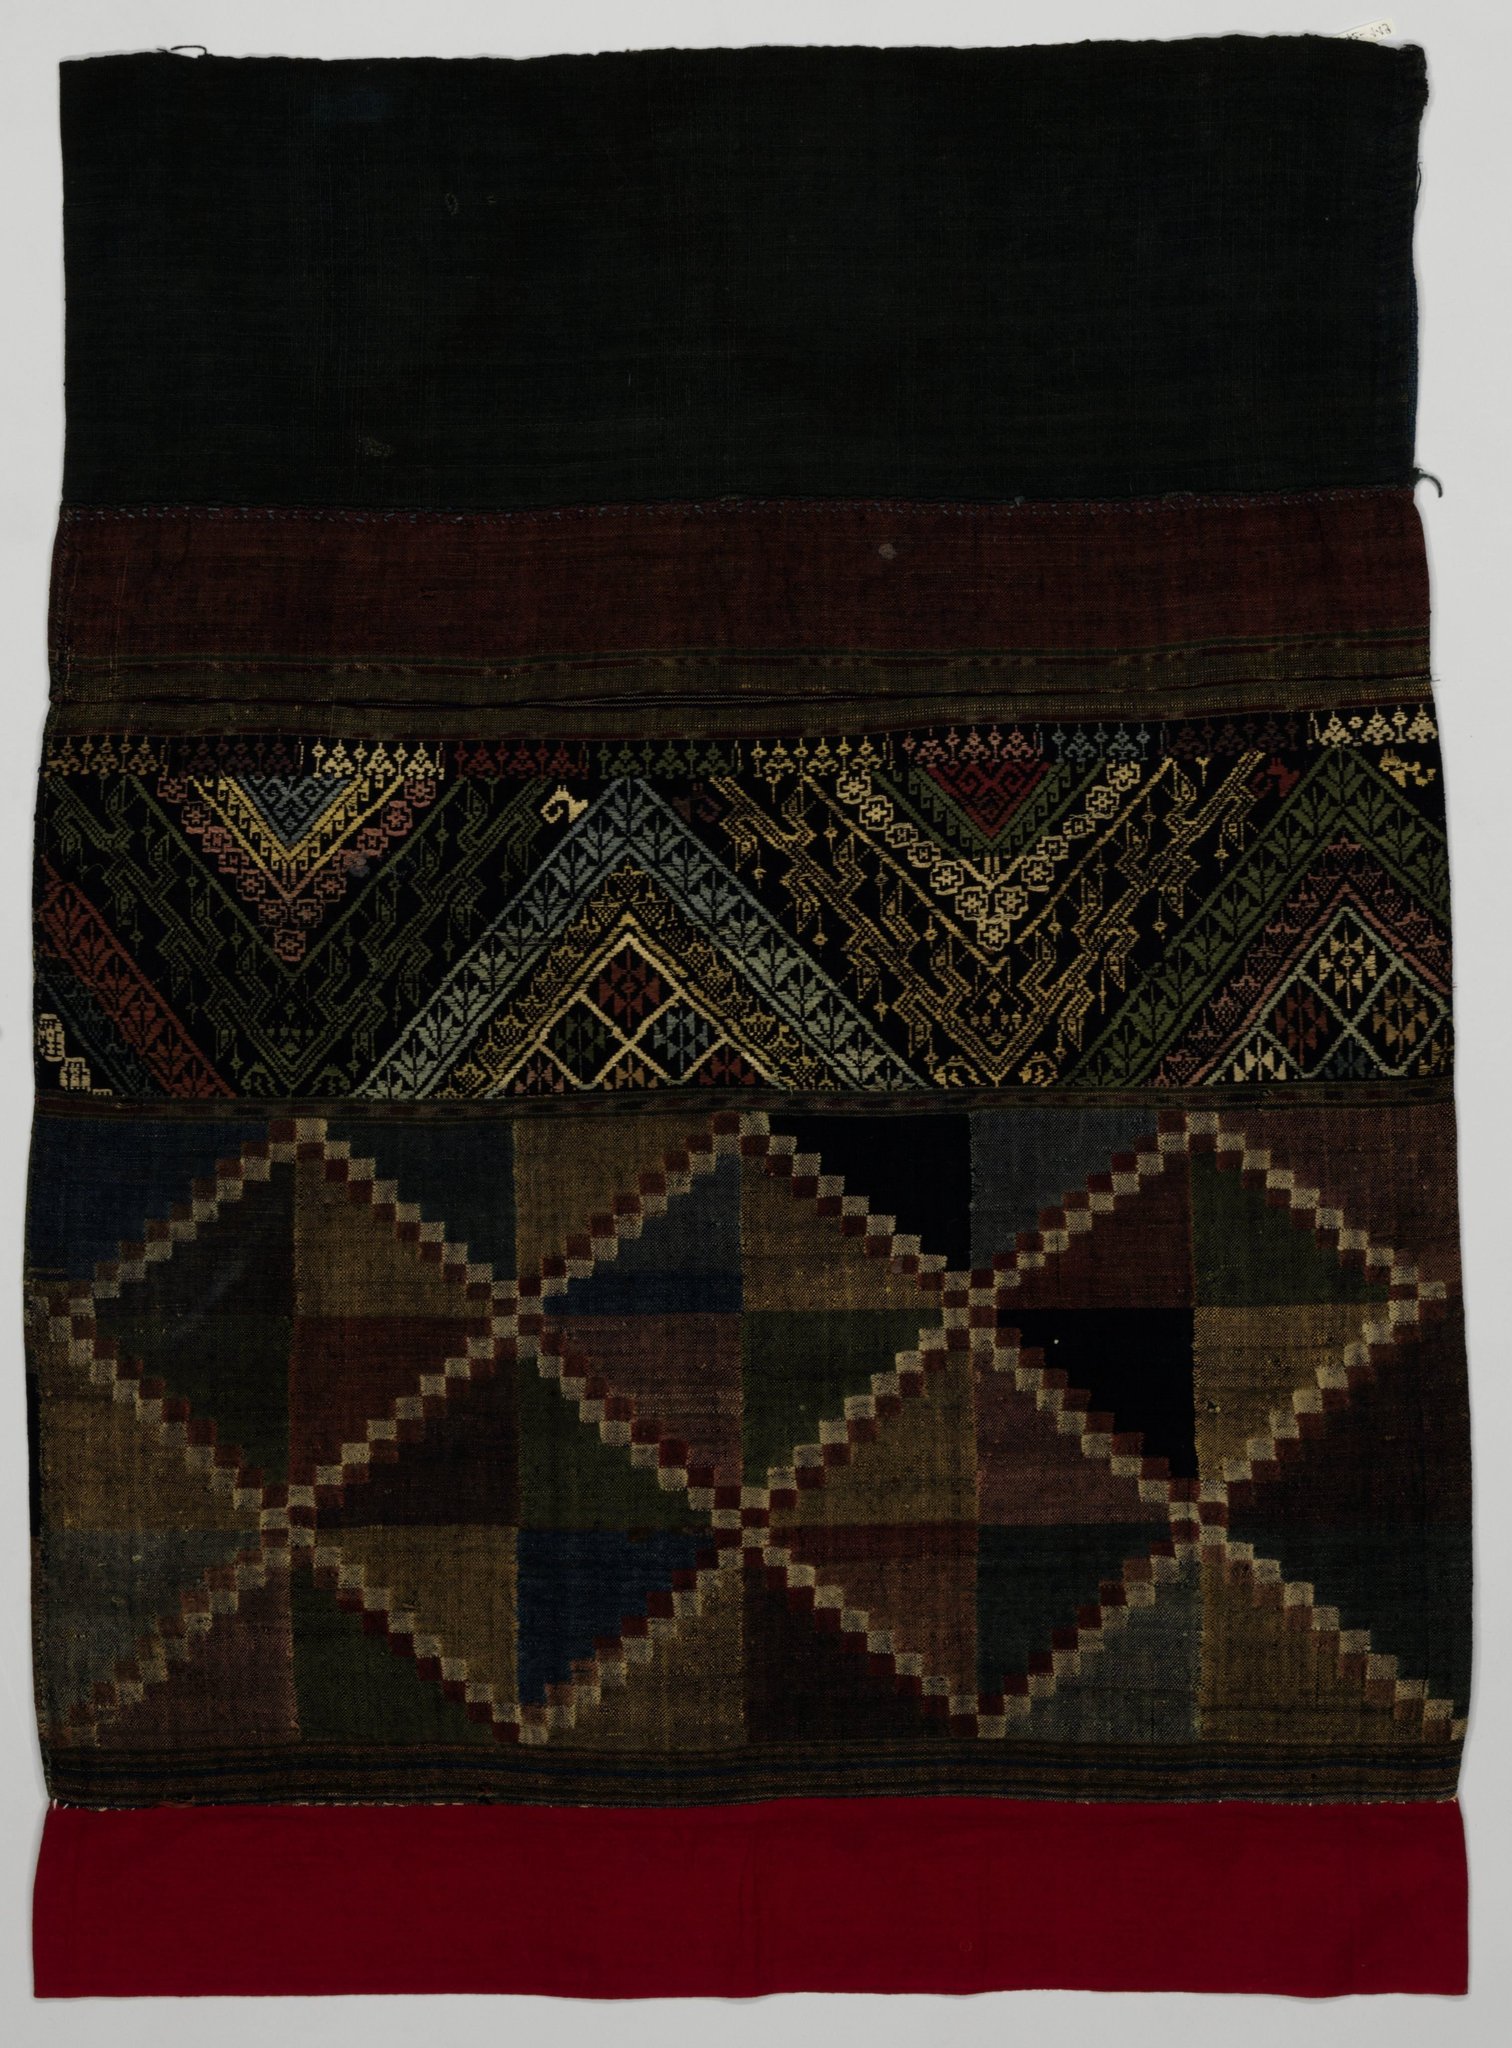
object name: cloth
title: Pa sin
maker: Anonymous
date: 1900-1949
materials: cotton, silk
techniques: weave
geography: laos